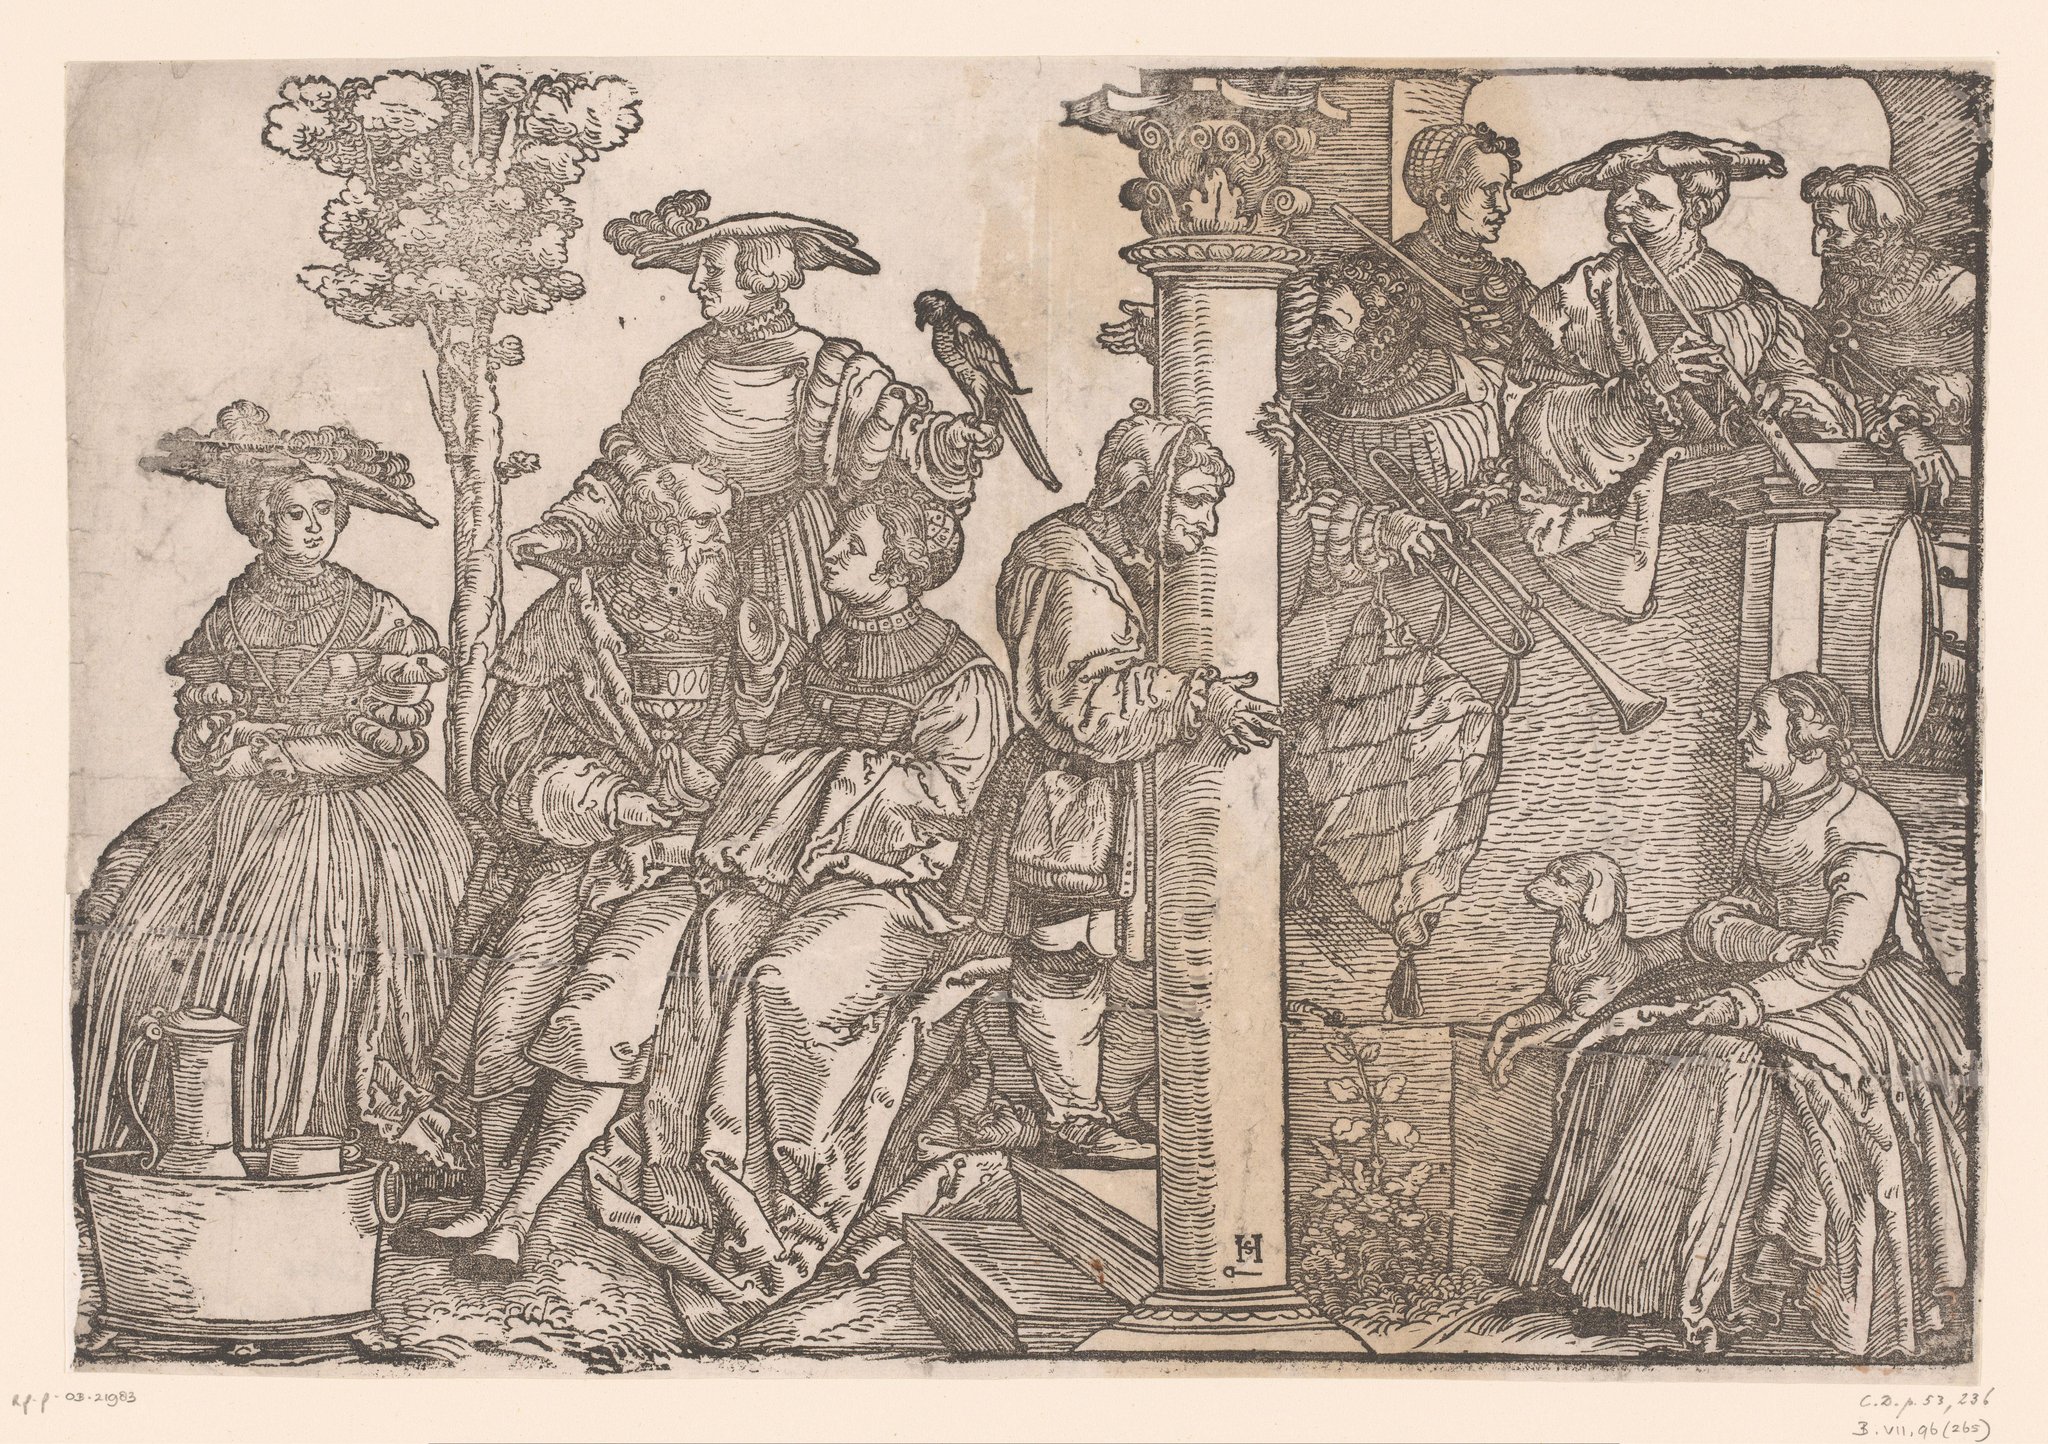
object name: print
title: Bruiloftsdansers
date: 1554-1572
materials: paper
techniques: woodcut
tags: dancing at wedding feast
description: Onderdeel van de tweede uitgave van een serie van 20 prenten met bruiloftsdansers.